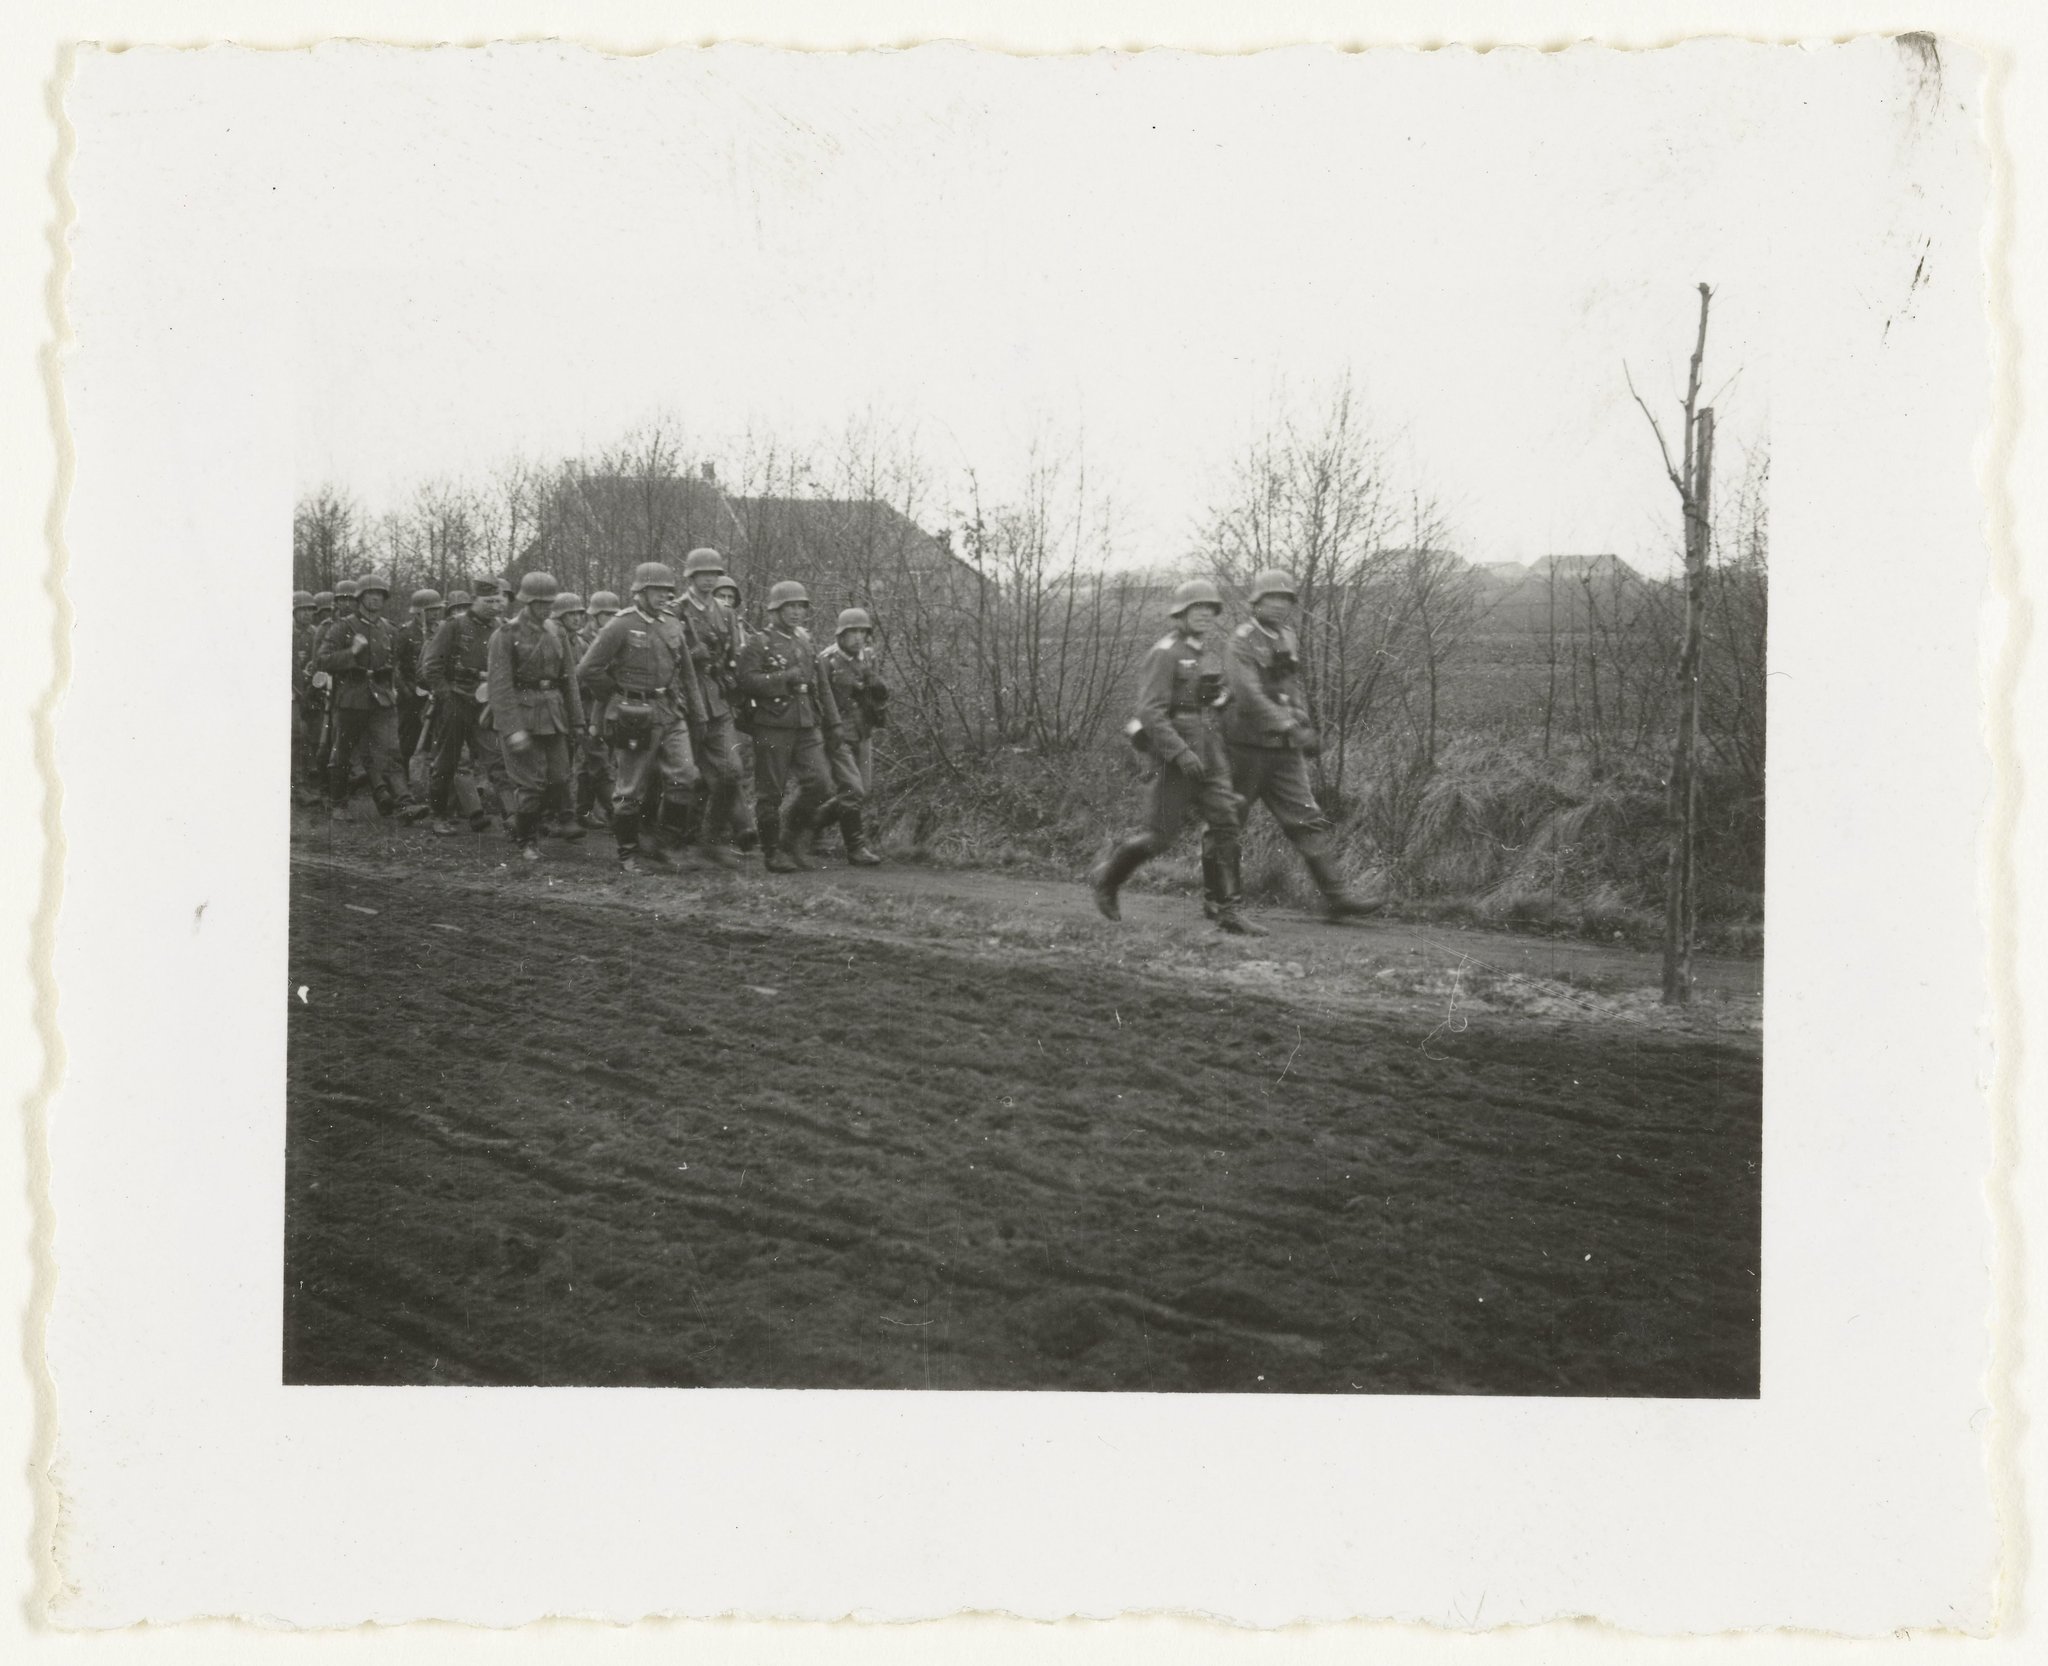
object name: photograph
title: Colonne Duitse soldaten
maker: Anonymous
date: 1904-1941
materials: photographic support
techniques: gelatin silver print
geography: netherlands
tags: army 'en route', review, inspection (of company, unit, troop), occupation ~ war, netherlands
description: Een colonne Duitse soldaten op mars. Ze dragen allen een helm. Achterop staat: In Holland. Auf dem Marsch mit Leutn. Busch. April 1941.